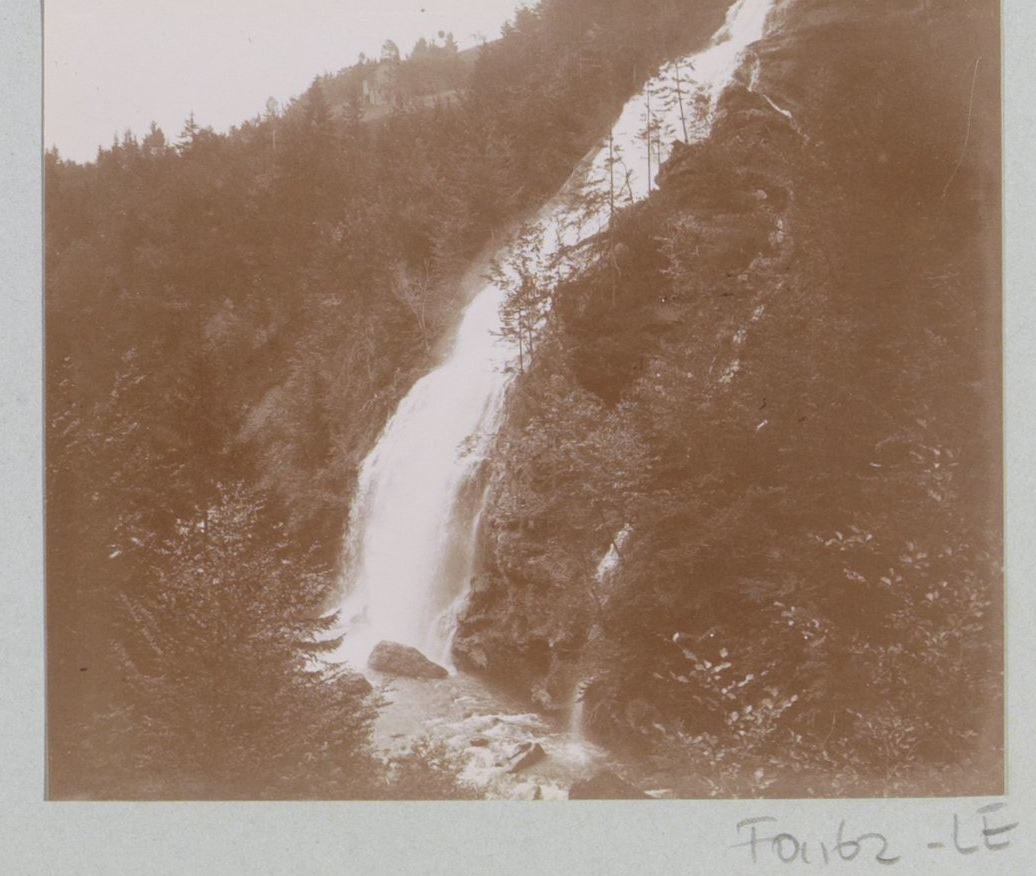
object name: photograph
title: Gezicht op een waterval, vermoedelijk in Frankrijk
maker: Anonymous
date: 1905-1910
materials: paper, photographic support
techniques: gelatin silver print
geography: france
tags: waterfall, france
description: Onderdeel van Fotoalbum van een Franse amateurfotograaf met bezienswaardigheden in Frankrijk, Zwitserland en Italië.